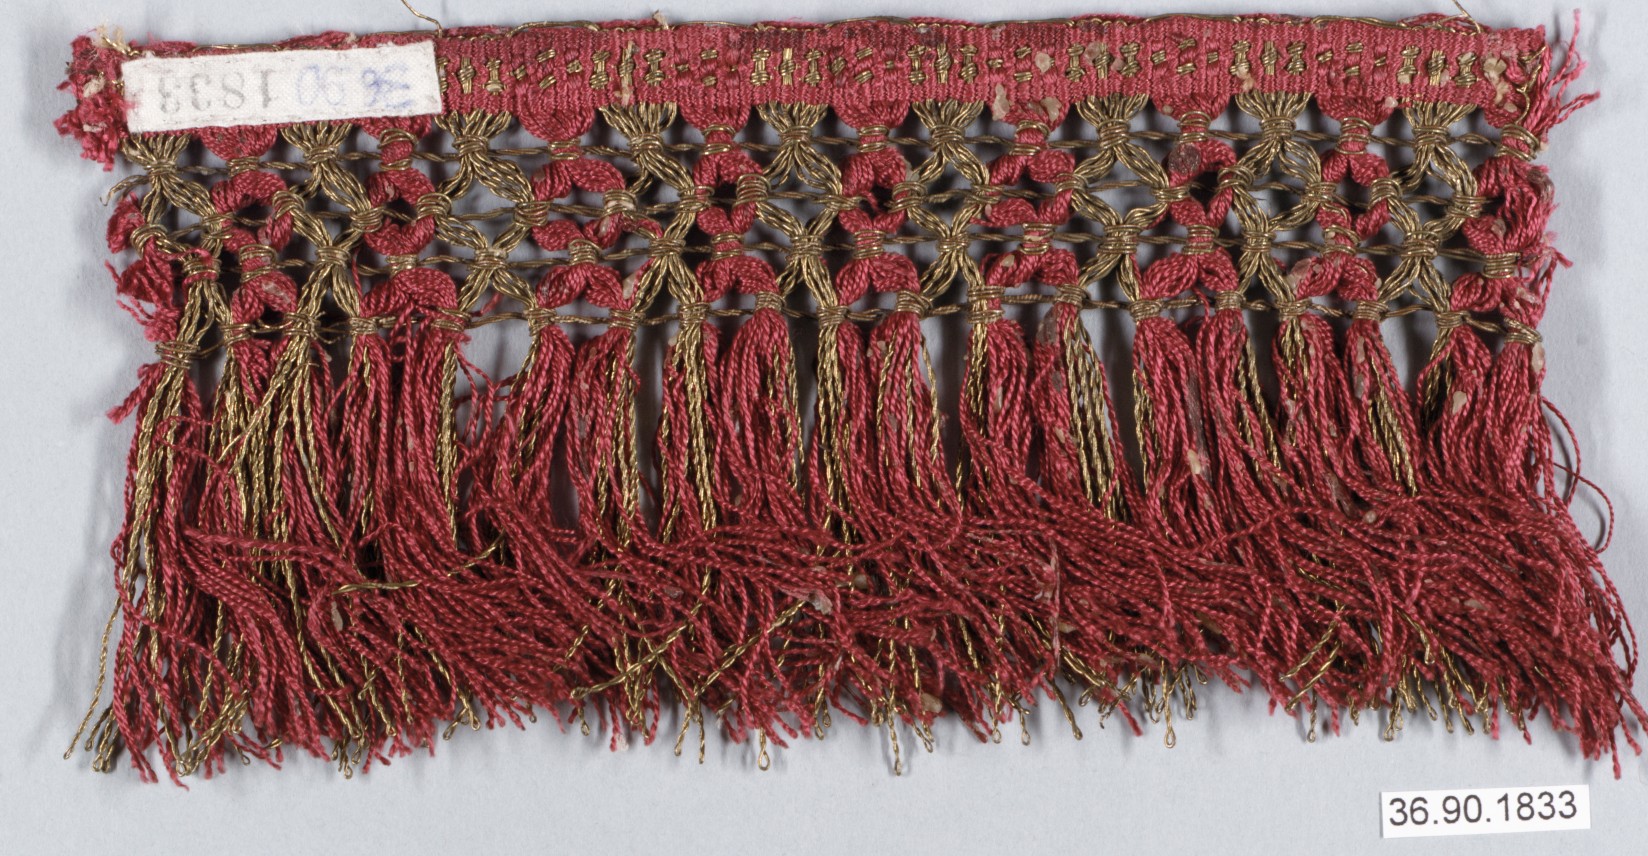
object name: fringe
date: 1734-1766